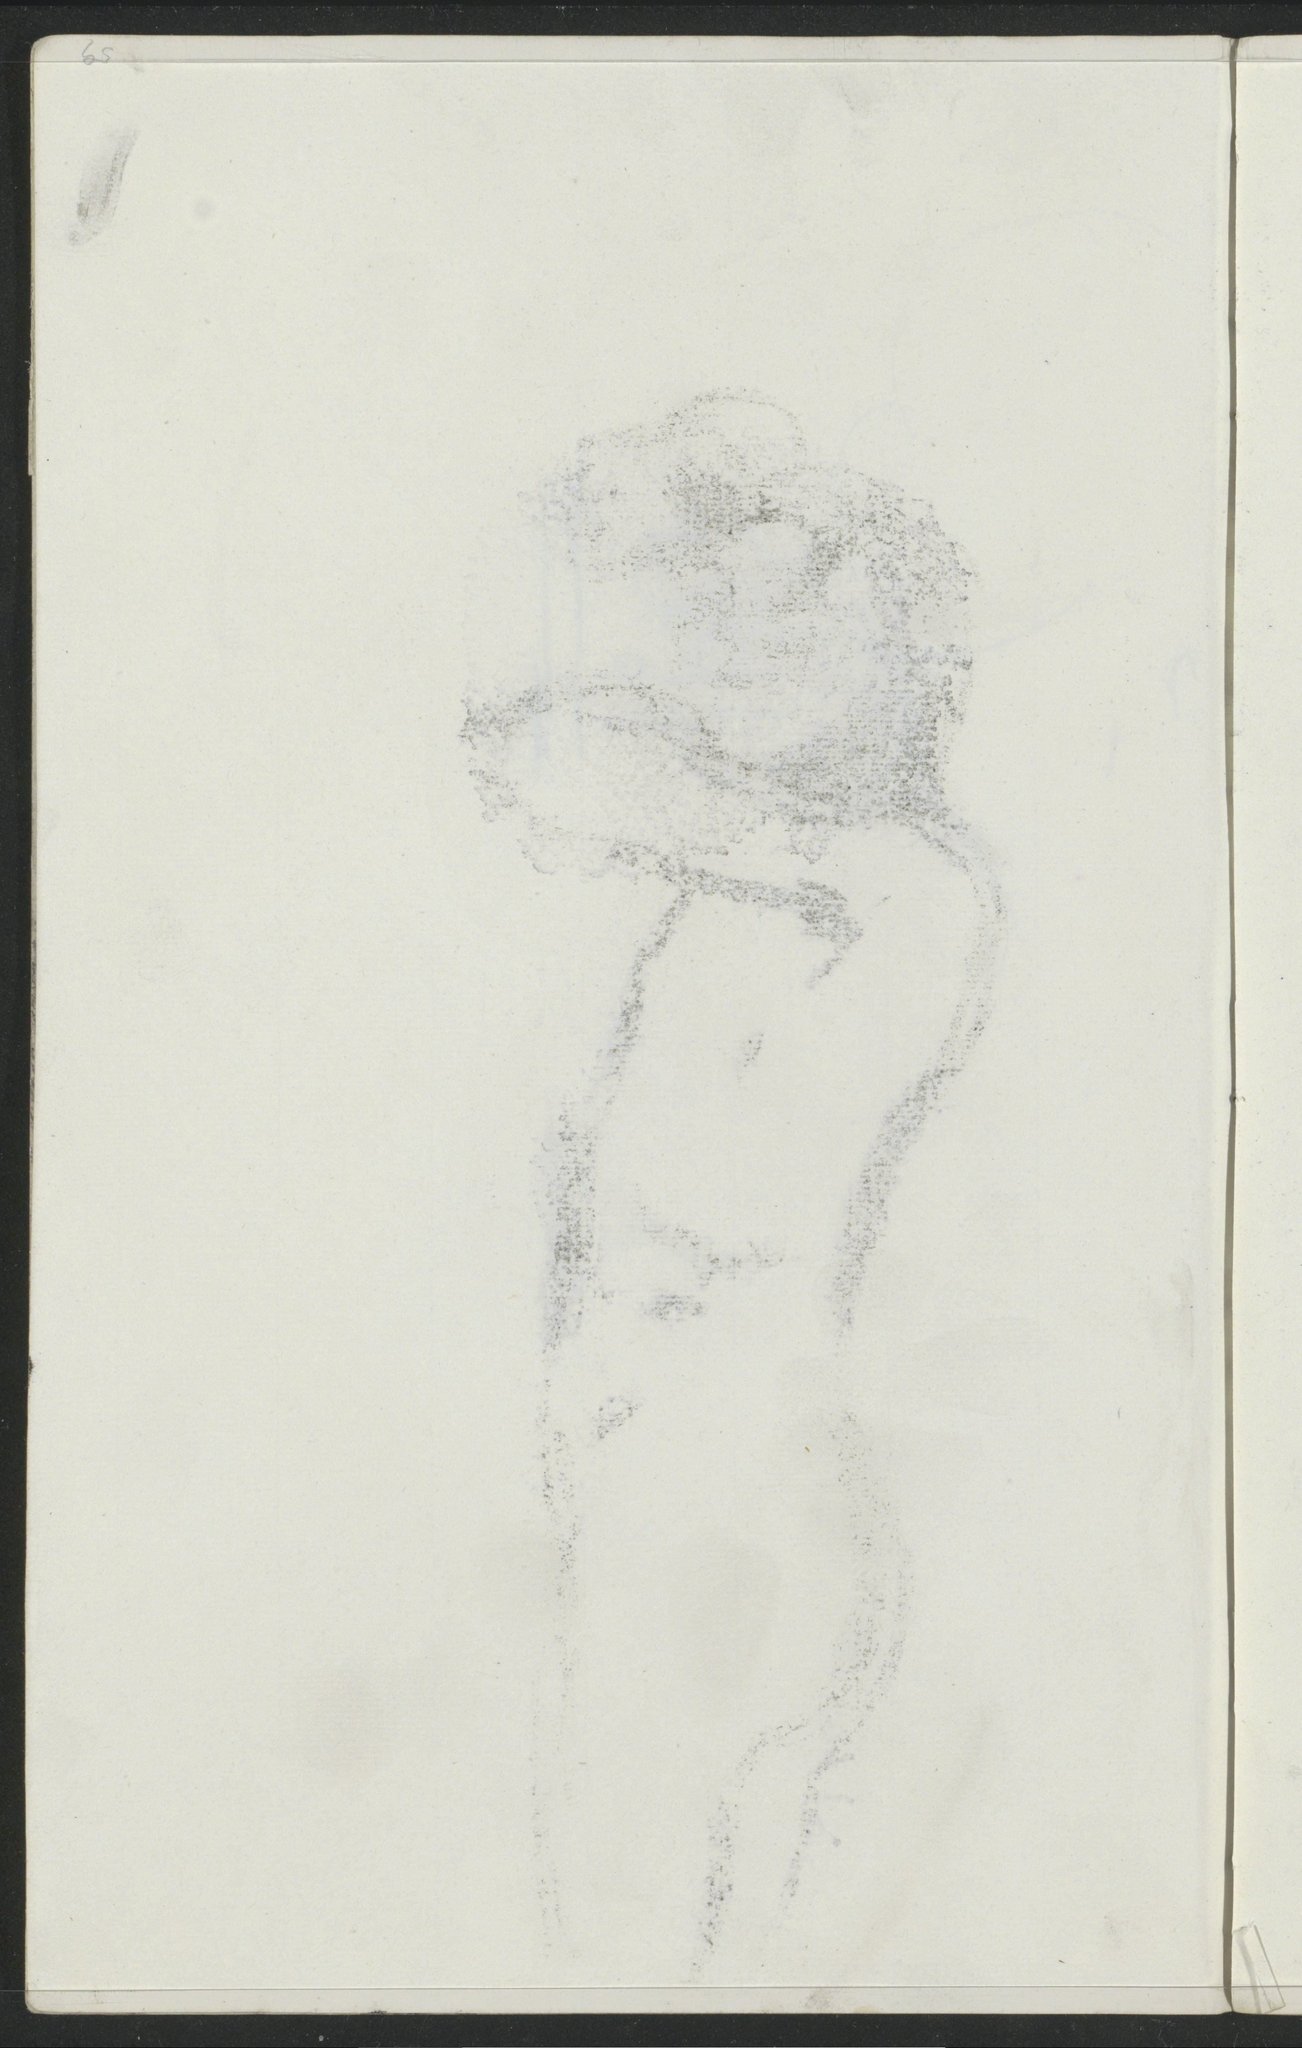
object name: sketchbook leaf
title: Abklatsch van de krijttekening op blad 3 recto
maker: isaac israels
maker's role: draughtsman, painter, print maker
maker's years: 1865-1934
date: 1875-1934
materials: paper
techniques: printmaking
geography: amsterdam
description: Blad 2 verso uit schetsboek XI met 30 bladen.